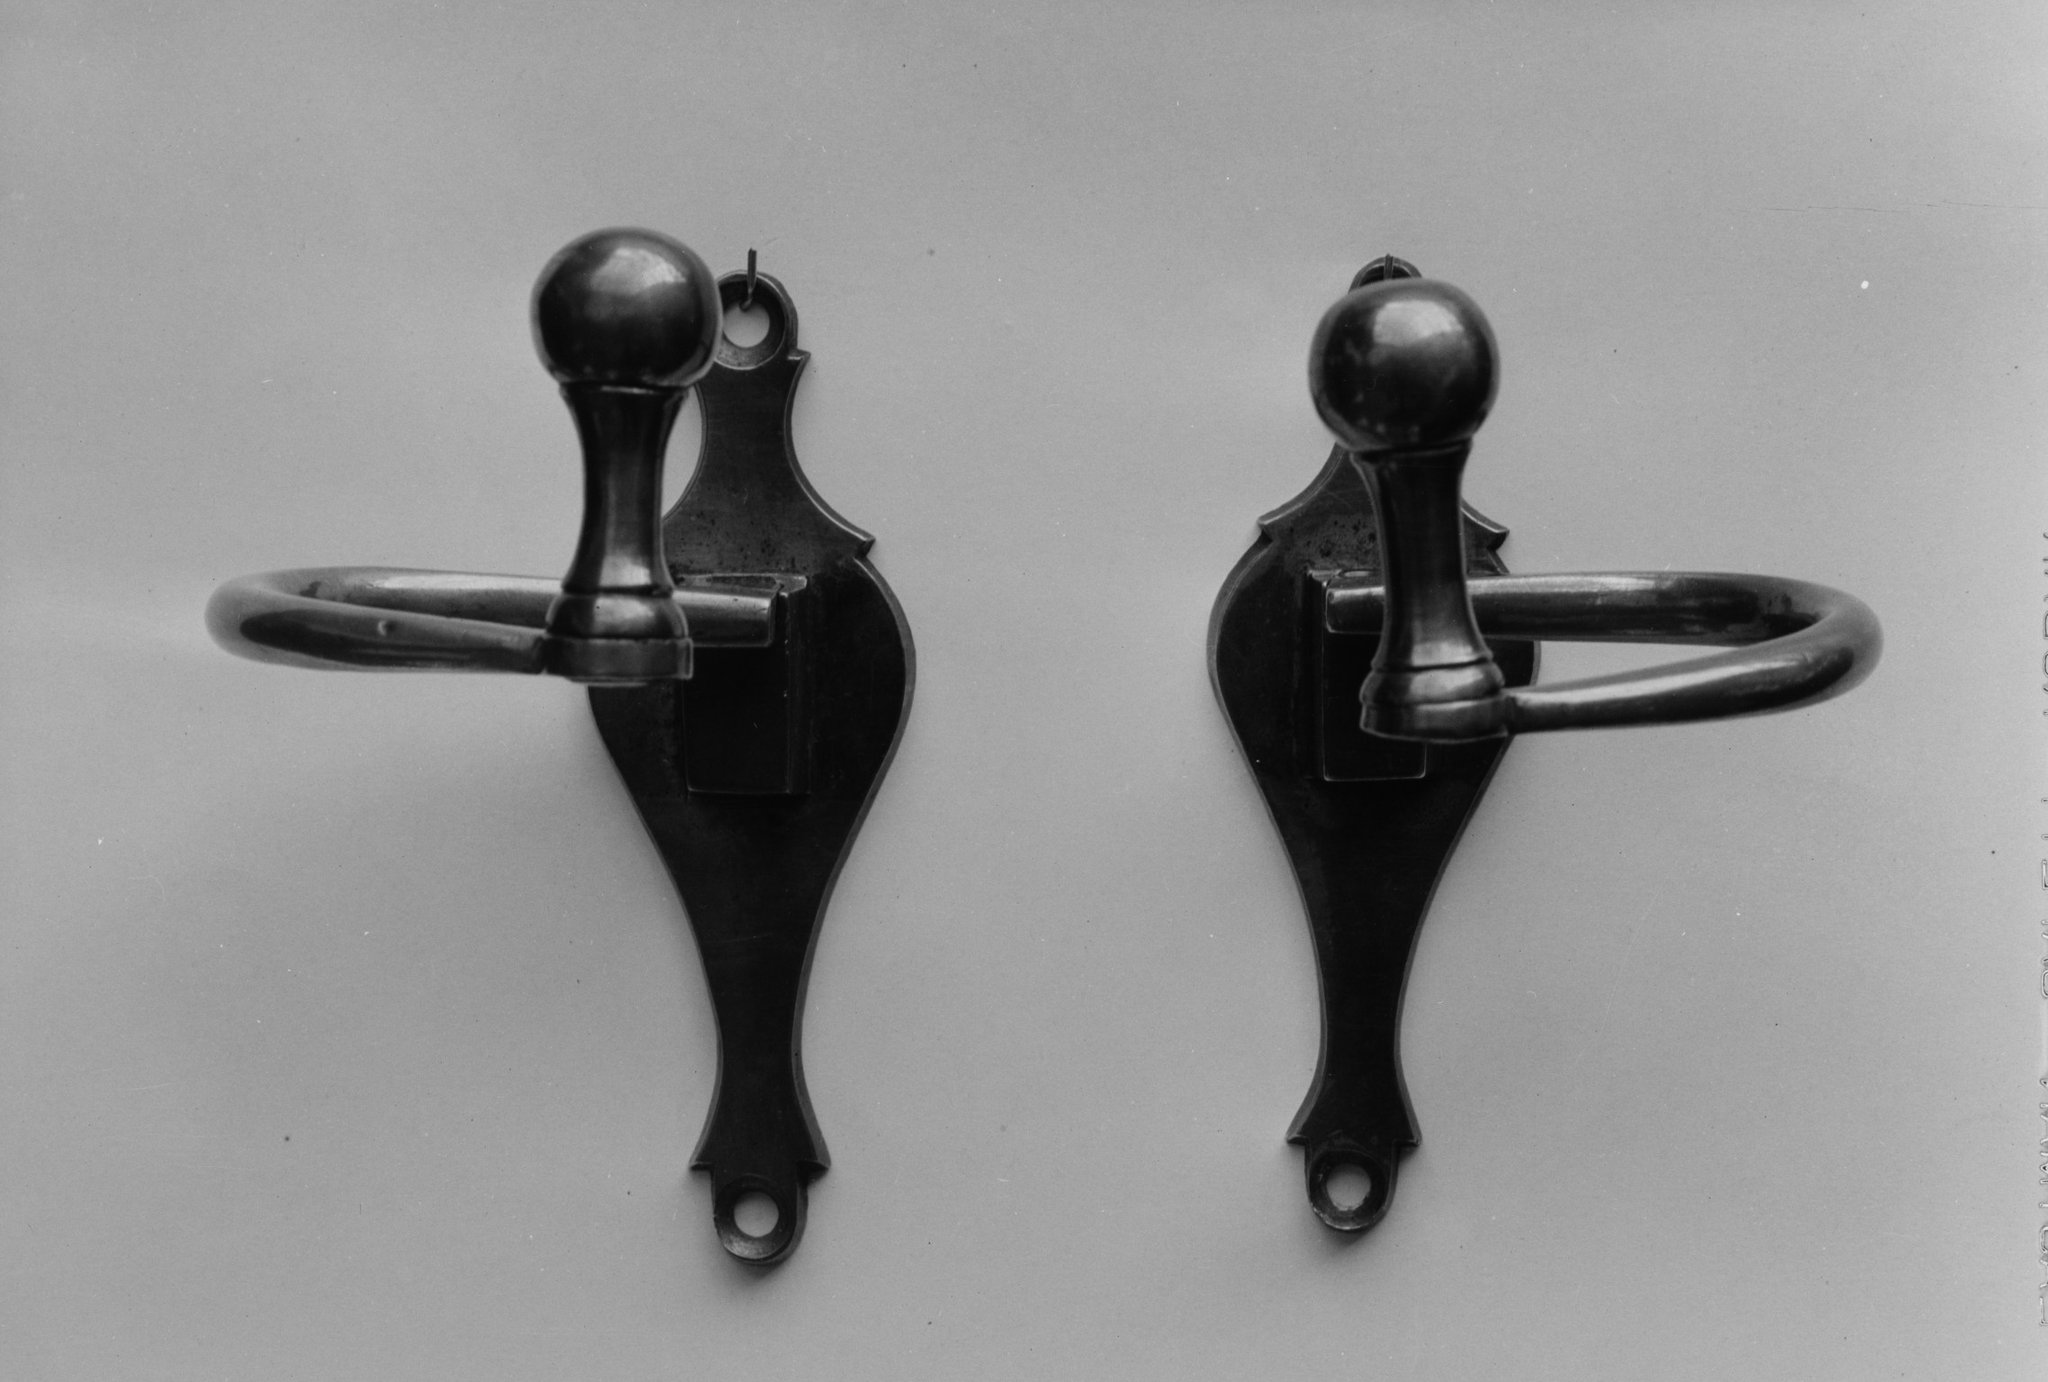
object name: jamb hook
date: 1750-1765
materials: iron, metal